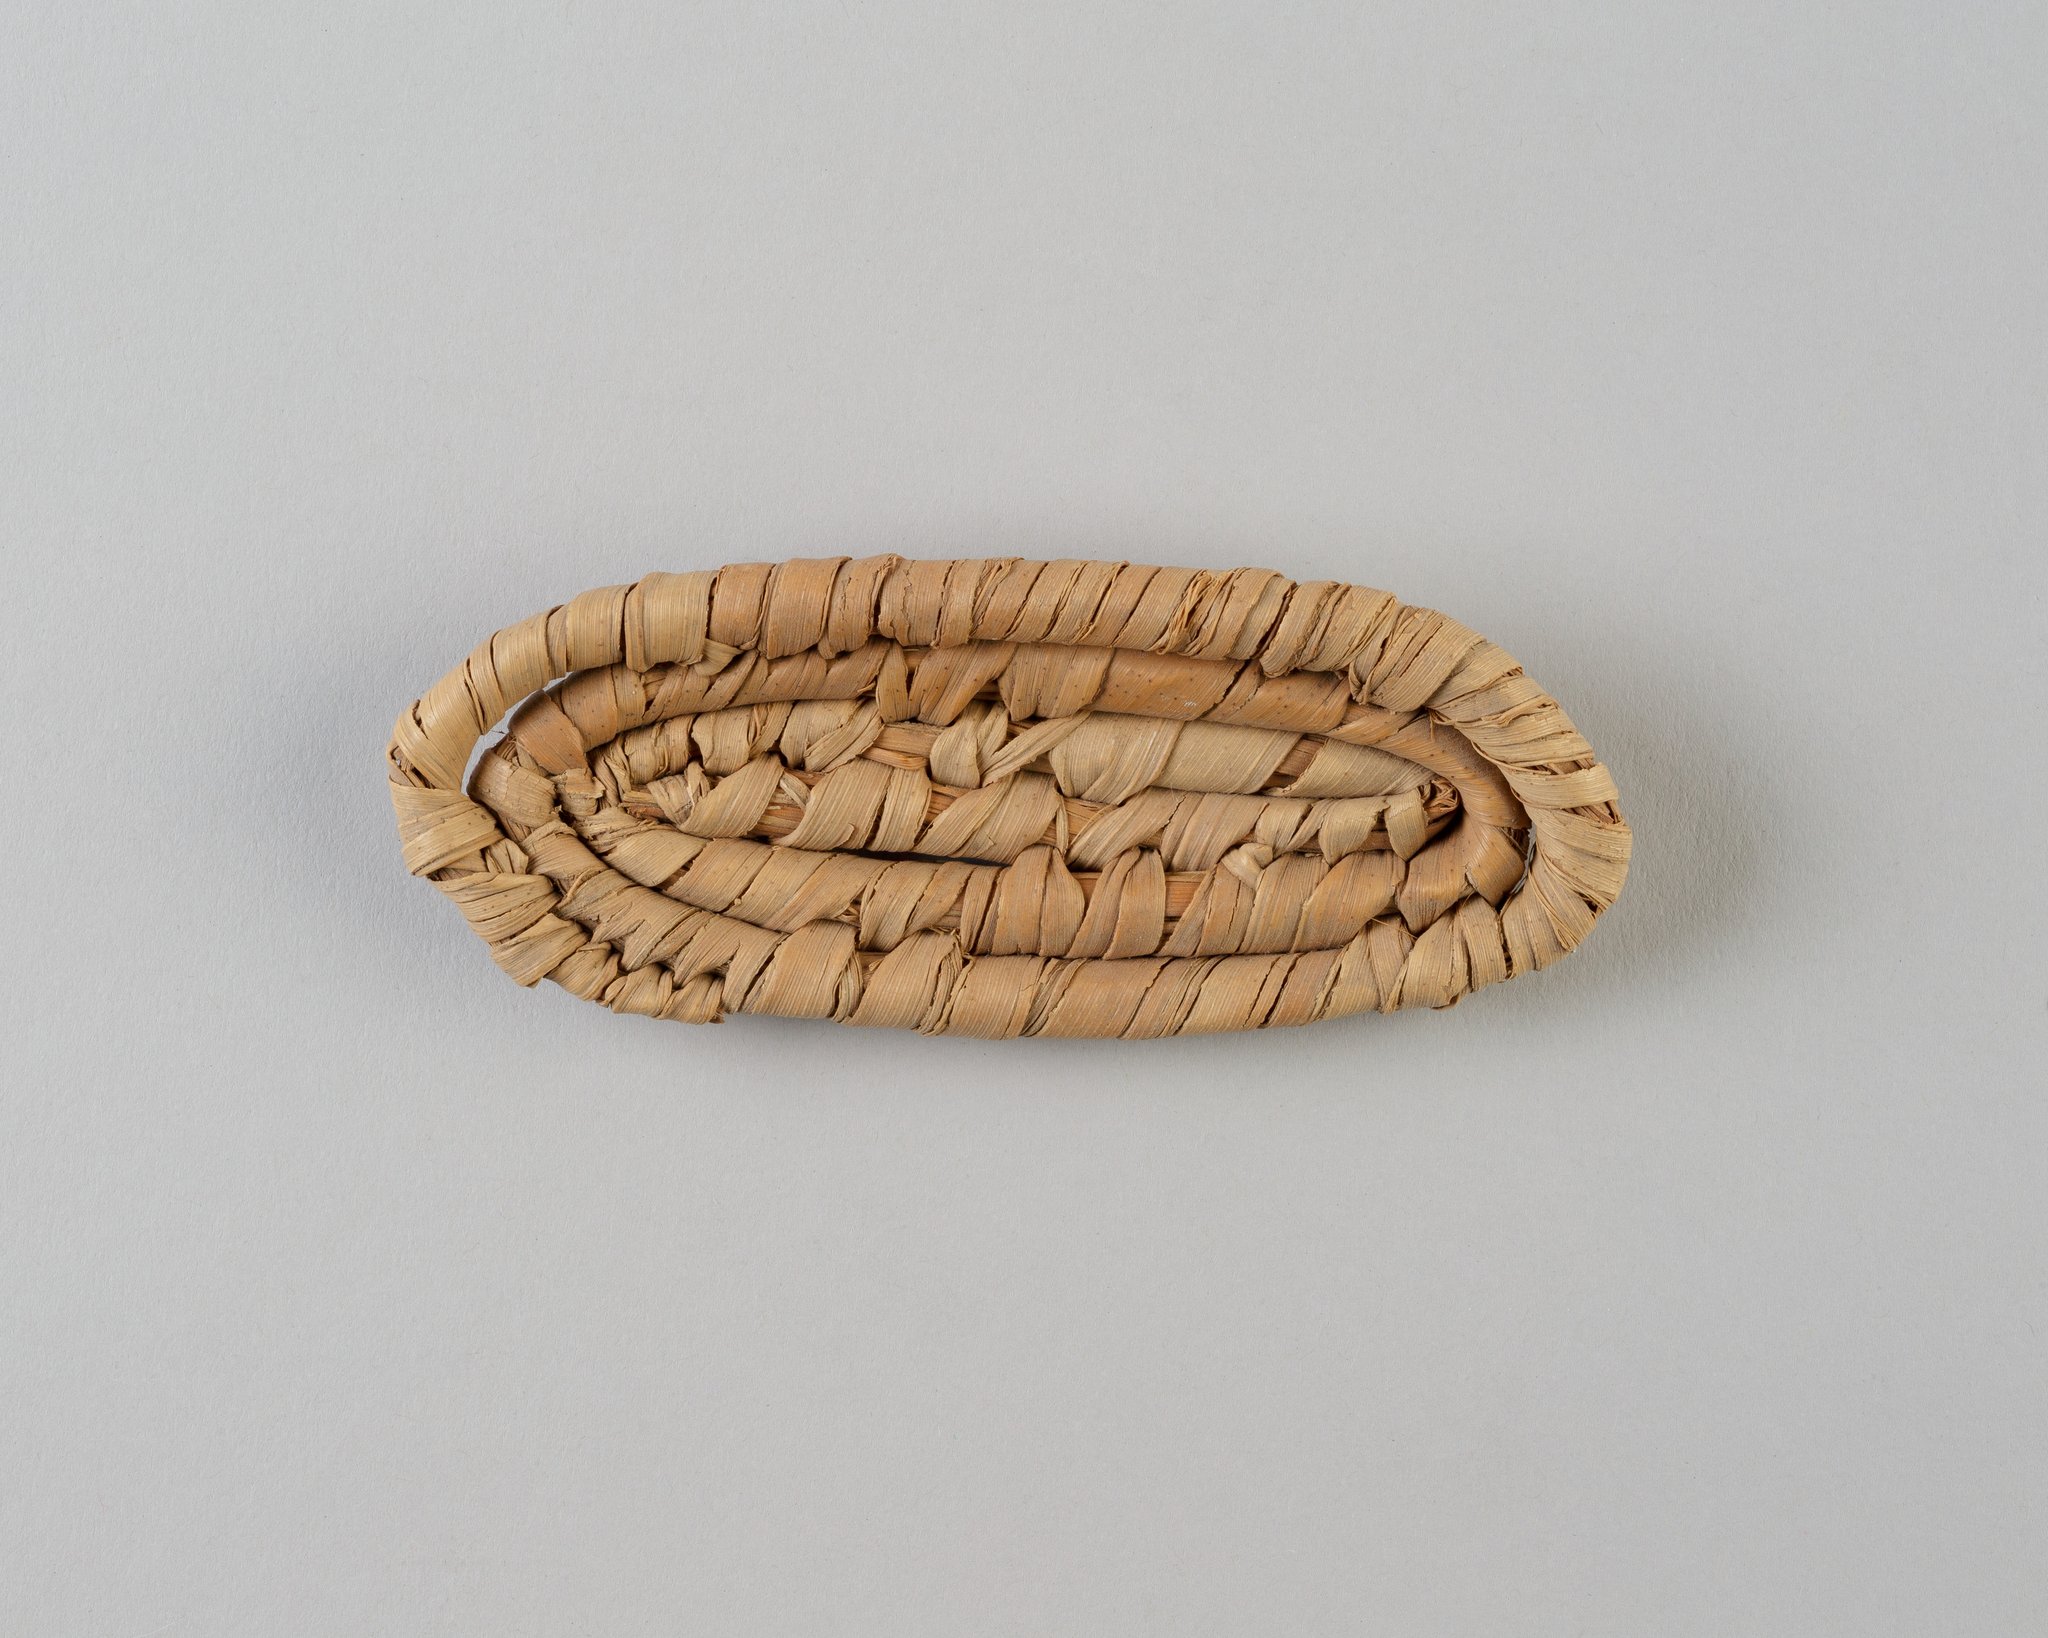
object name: basketry, model, senenmut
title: Tray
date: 1479-1458 BCE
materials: leaf, fiber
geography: egypt